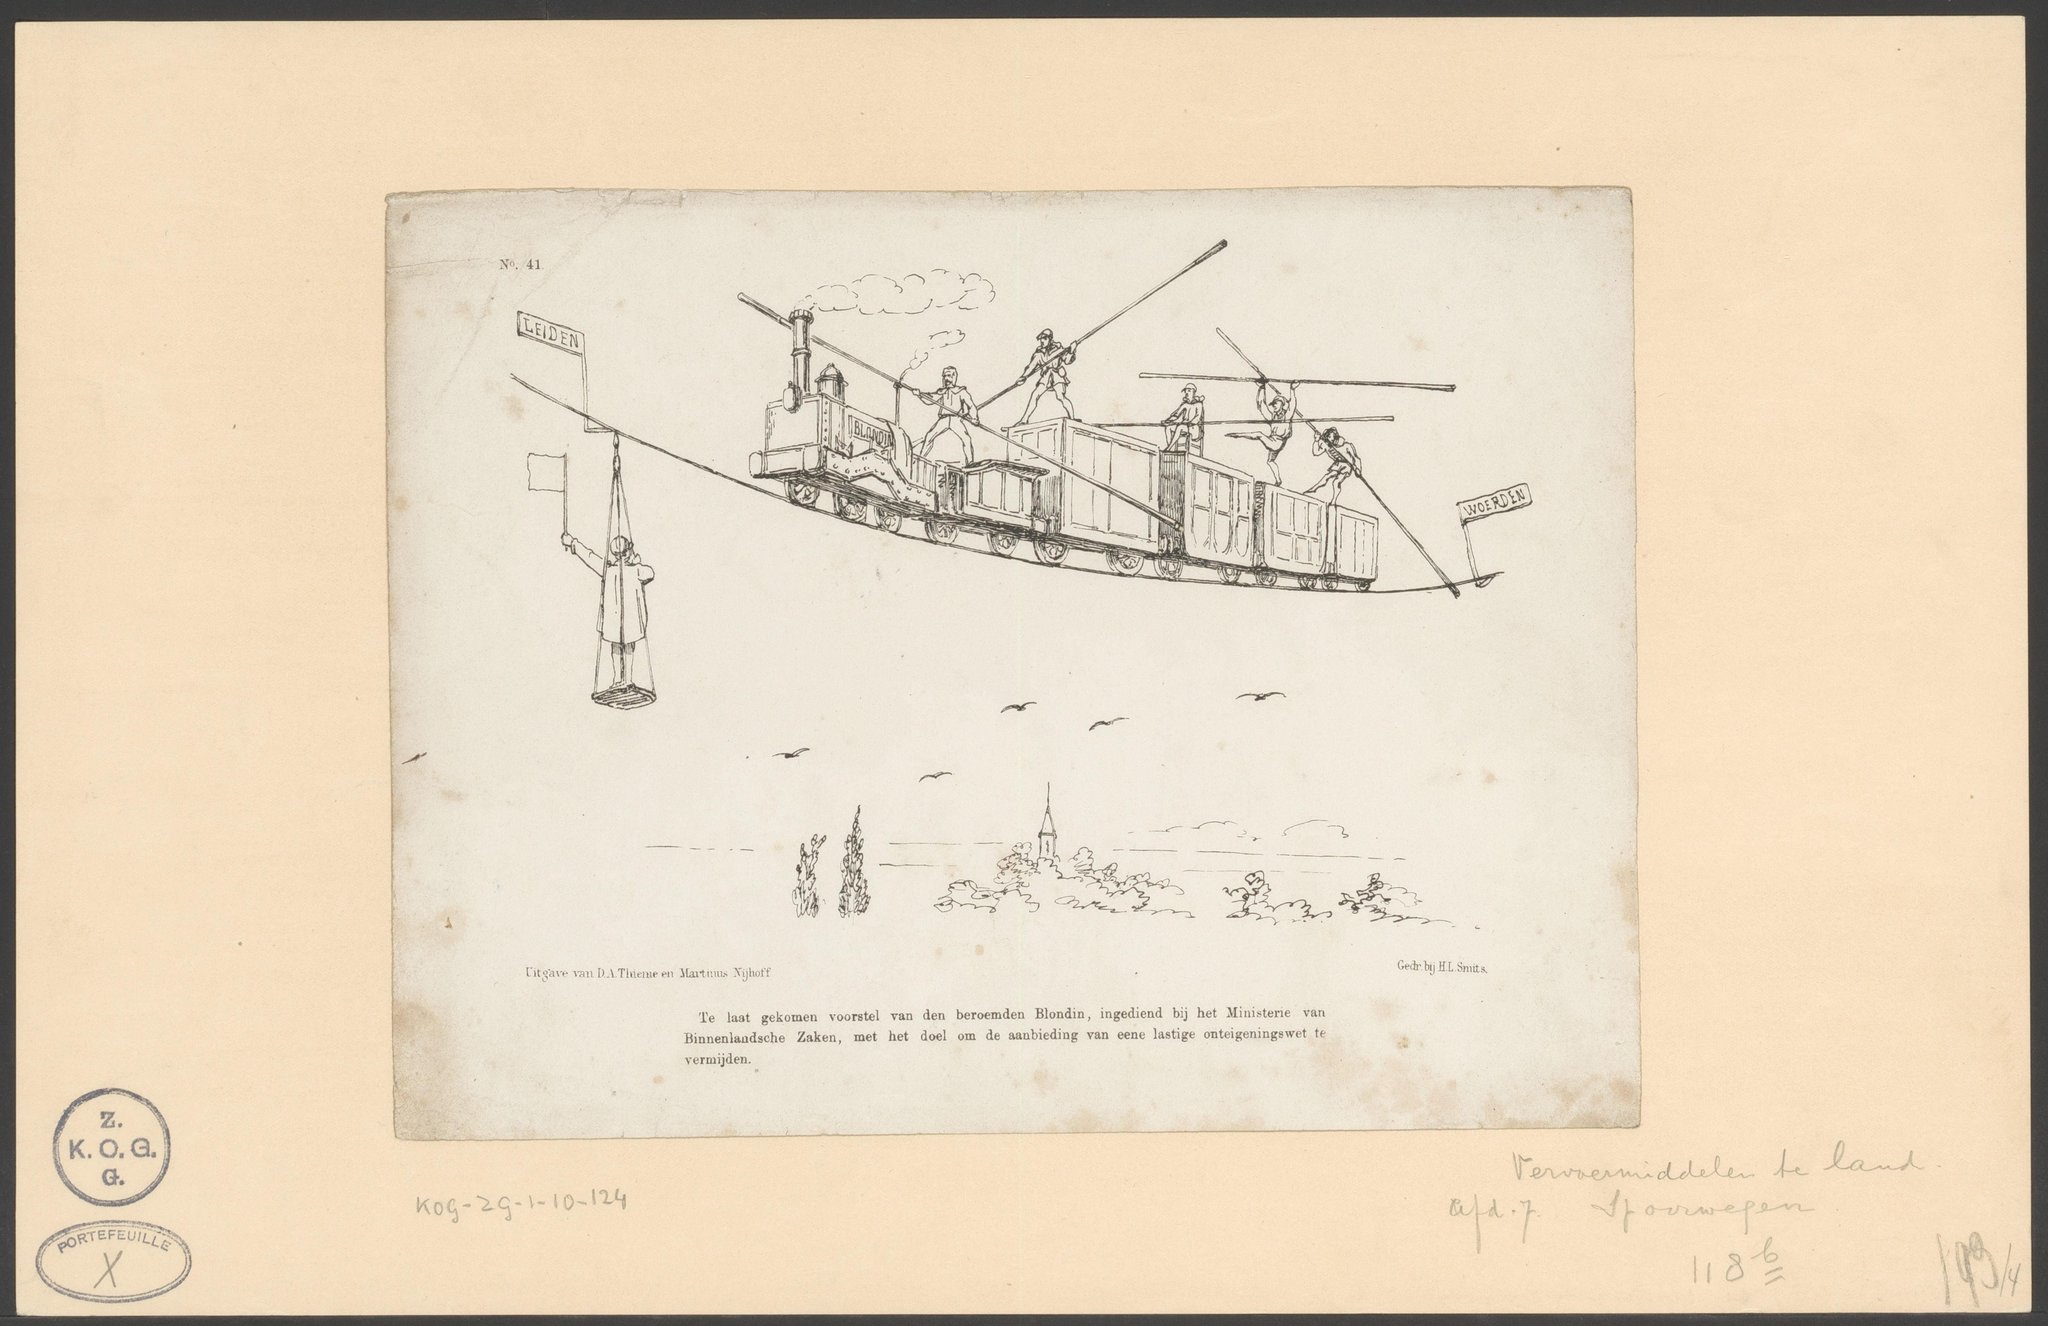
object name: print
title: Spotprent op de Rotterdamse bezwaren tegen de onteigeningswet, 1861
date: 1861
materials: paper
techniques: lithograph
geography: the hague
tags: railway, train, tight-ropewalker, steam locomotive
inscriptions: collector's mark: Lugt 1641, stamp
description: Bovenaan genummerd: No. 41. Onderwerpsrubrieken binnen de Atlas Zeden en Gewoonten: Handel, nijverheid en verkeer, Vervoermiddelen te land en te water, vervoermiddelen te land, Spoorwegen.